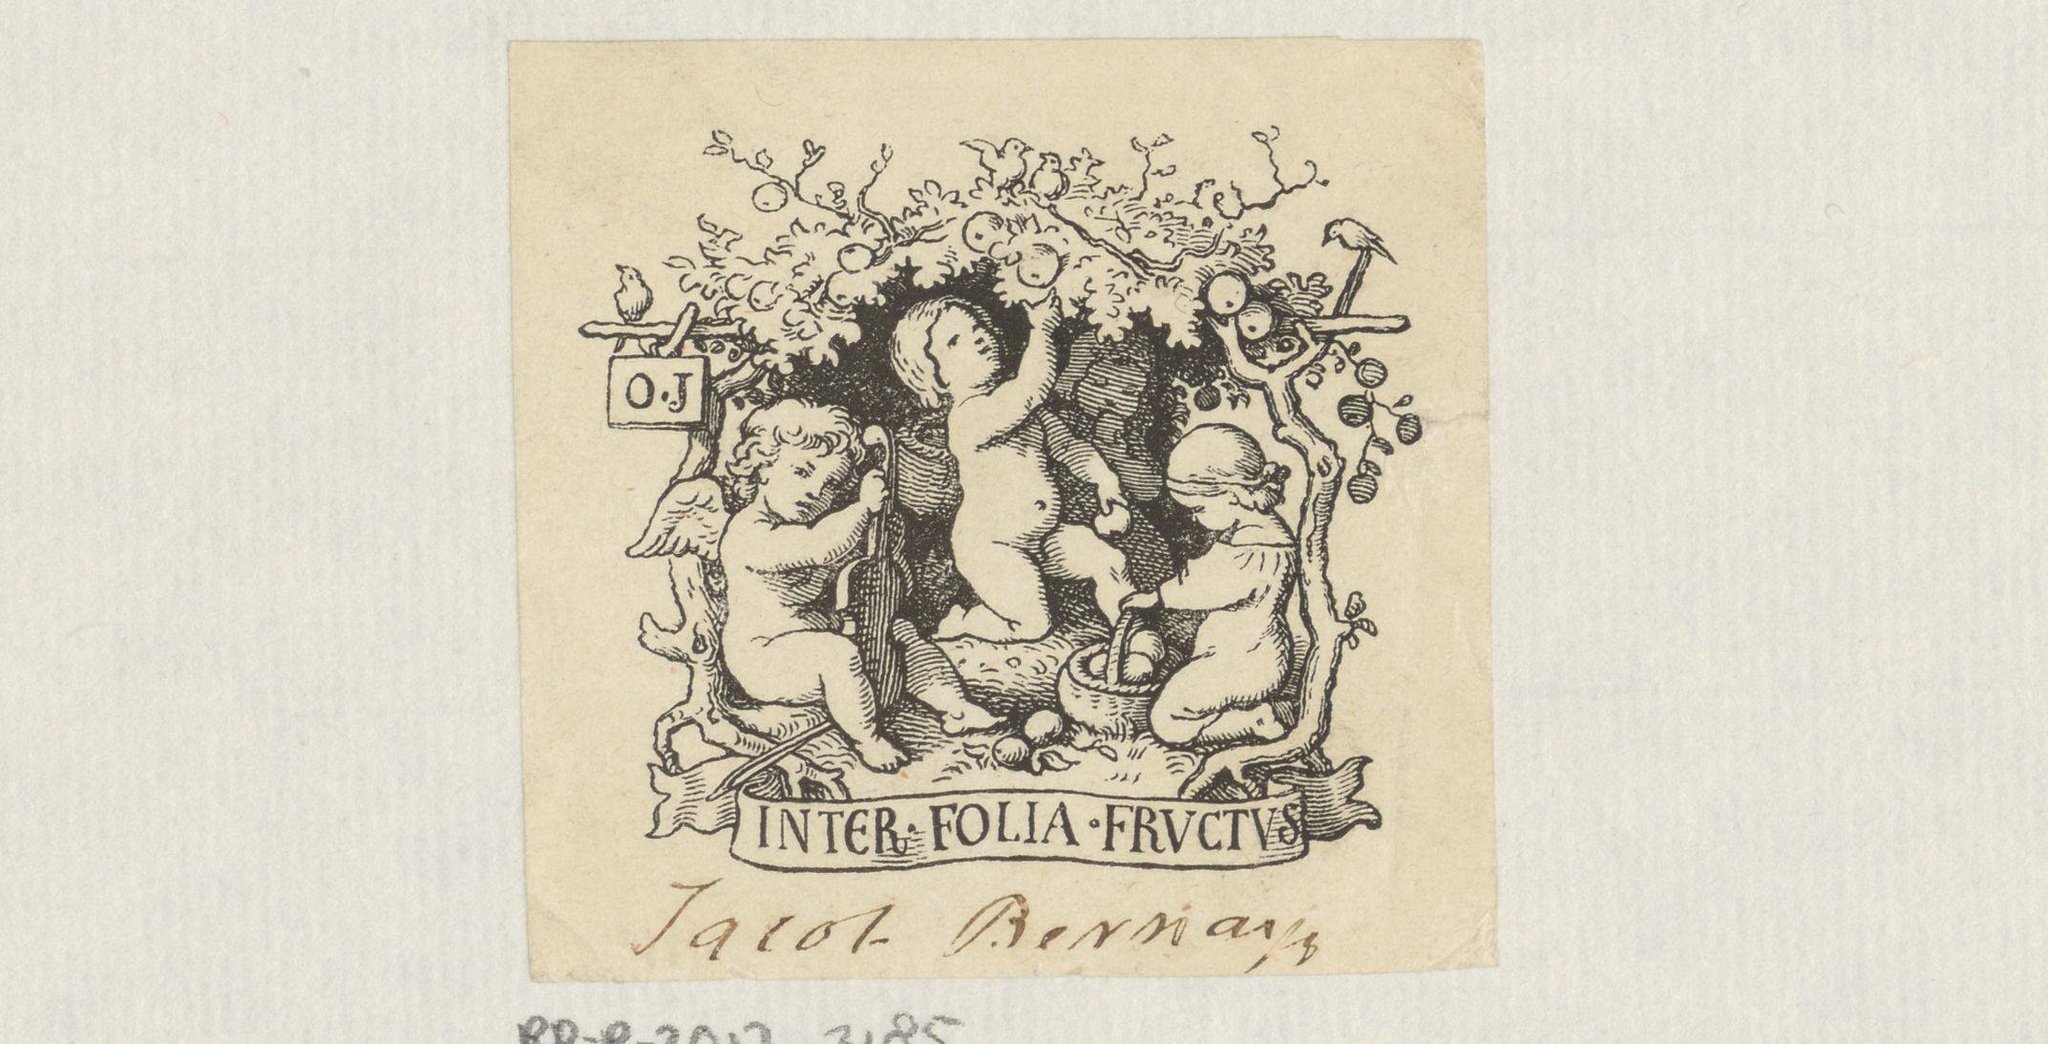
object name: bookplate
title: Ex libris van Otto Jahn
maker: Anonymous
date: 1823-1869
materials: paper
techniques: printing block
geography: germany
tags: violin, fiddle, fishes, infant, baby, fruit harvest, cupids: 'amores', 'amoretti', 'putti'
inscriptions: inscription: ‘Jacob Bernar (?)’